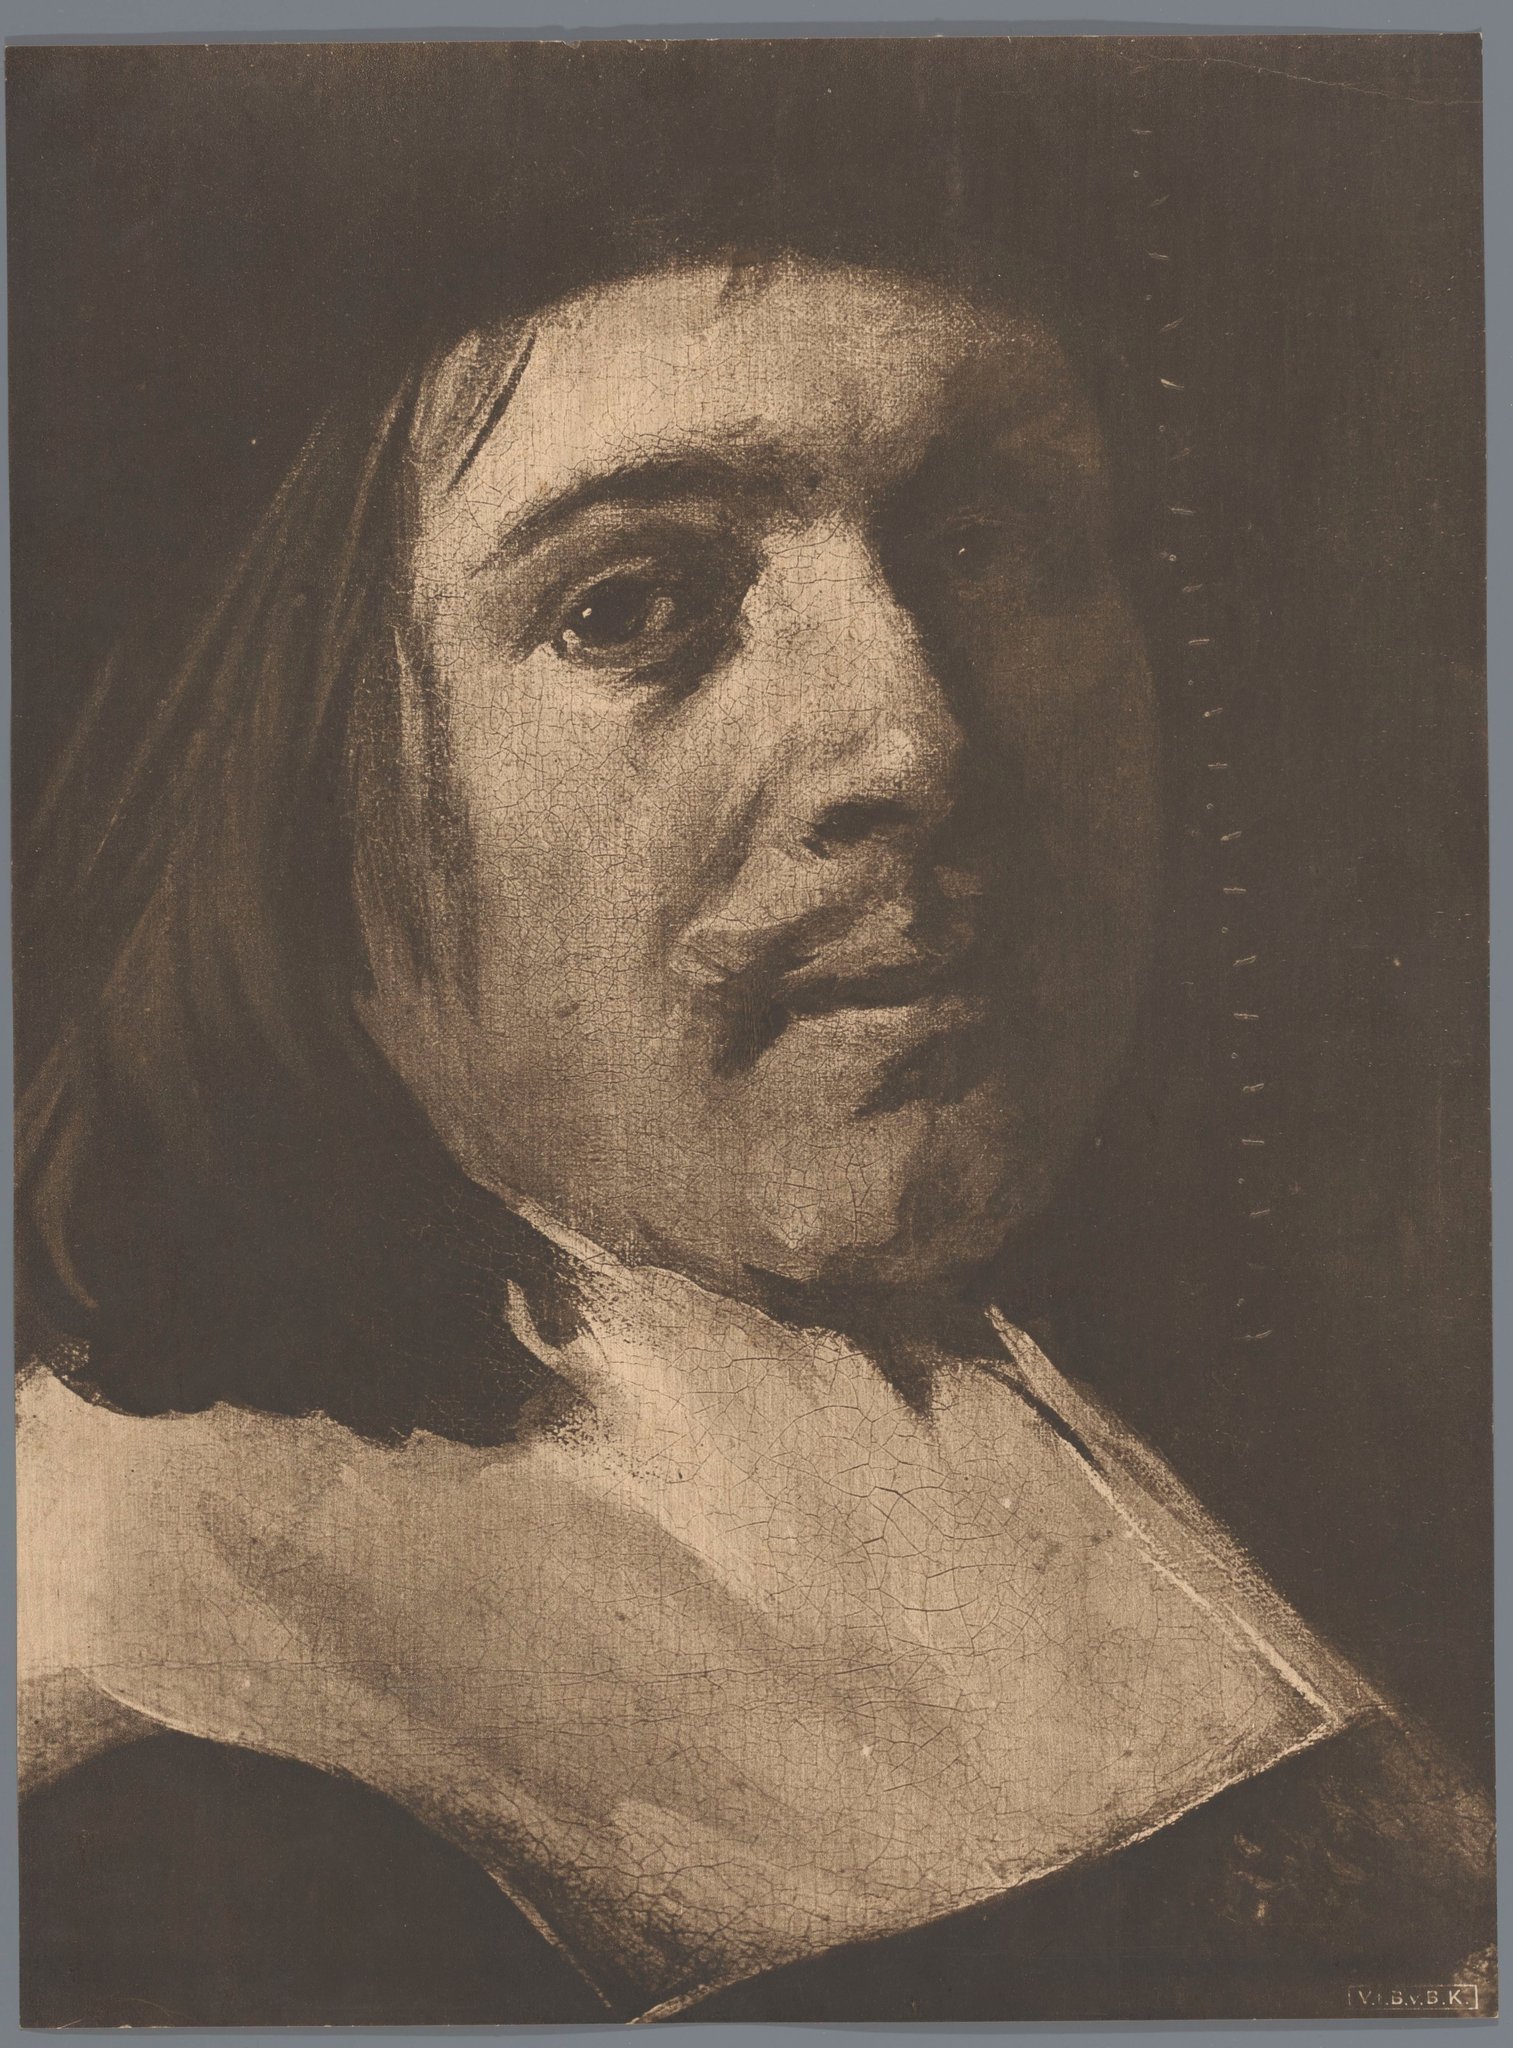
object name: photograph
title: Portret van een man met een kraag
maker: Anonymous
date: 1875-1900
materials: paper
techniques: photography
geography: europe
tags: anonymous historical person portrayed, neck-gear: collar, europe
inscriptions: name: ‘V.t.B.v.B.K.’